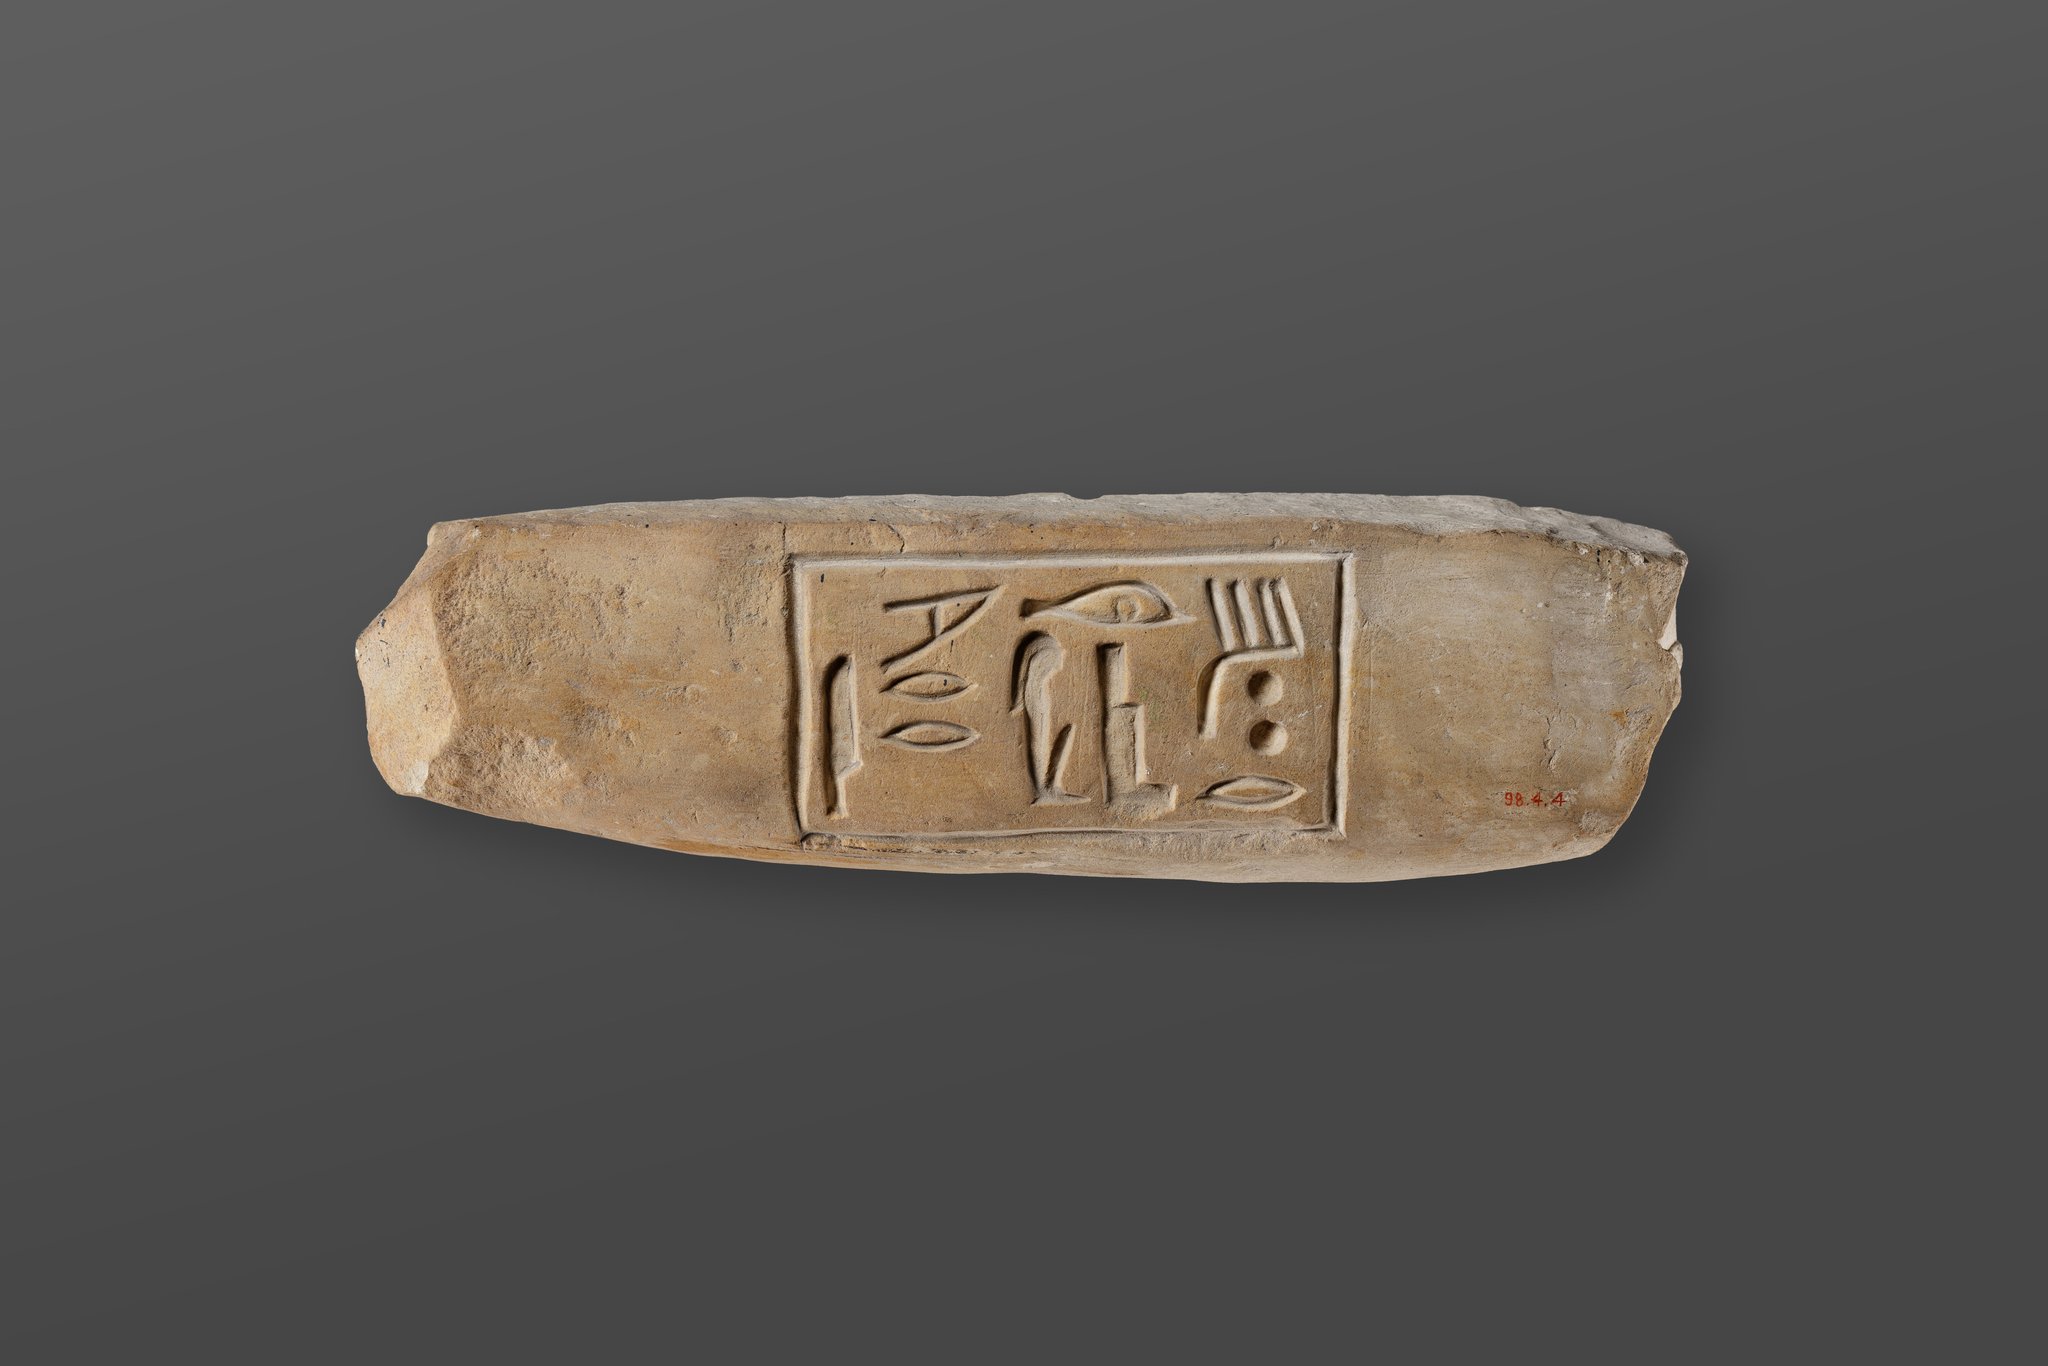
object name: door drum section, tomb of mereri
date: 2100-2030 BCE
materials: limestone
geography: egypt